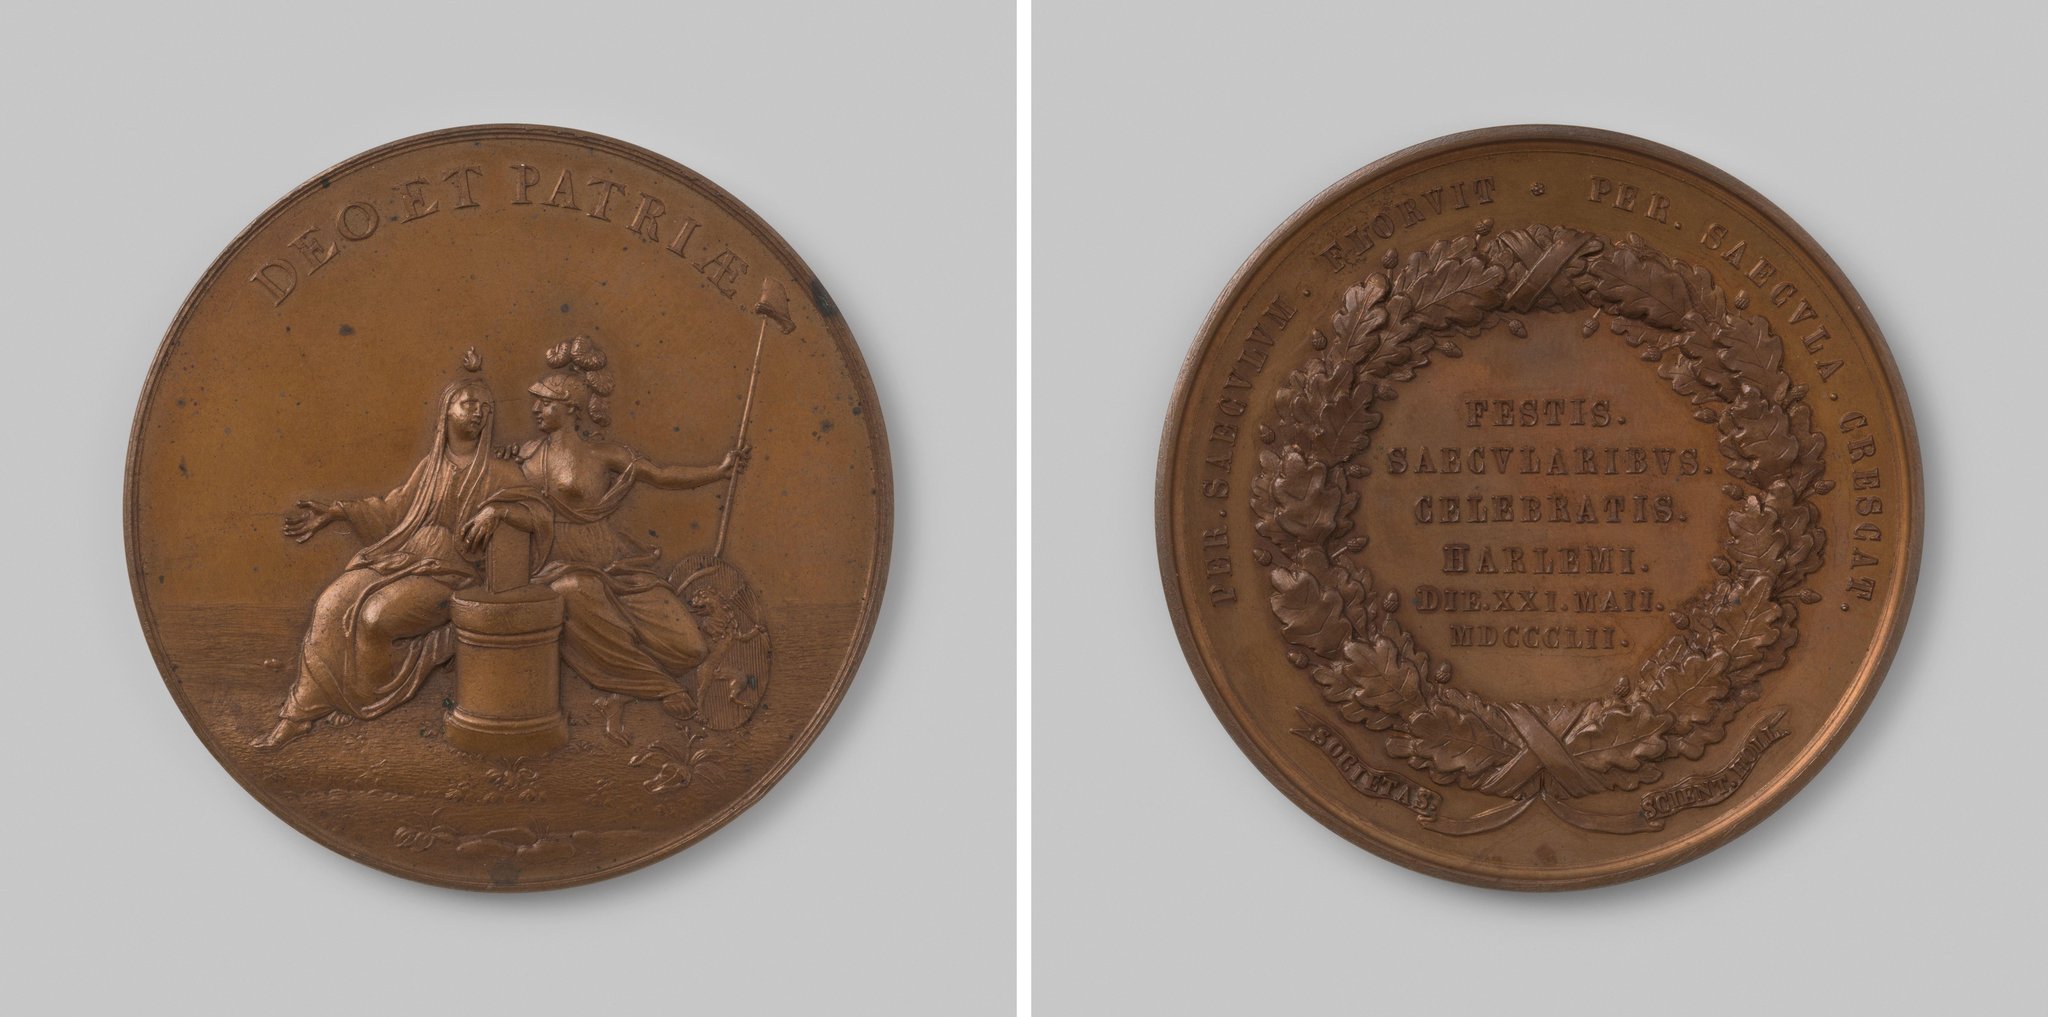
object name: history medal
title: Eerste eeuwfeest van de Hollandsche Maatschappij der Wetenschappen te Haarlem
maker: johan george holtzhey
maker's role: mintmaster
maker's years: 1726-1808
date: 1852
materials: bronze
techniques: striking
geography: amsterdam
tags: haarlem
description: Bronzen penning. Voorzijde: twee vrouwen zittend bij altaar, voorstellend Godsdienst met vlam op hoofd en leunend op bijbel en Nederland met wapenschild en vrijheidshoed op speer binnen omschrift. Keerzijde: opschrift binnen eikekrans, waaraan lint met opschrift hangt, en omschrift